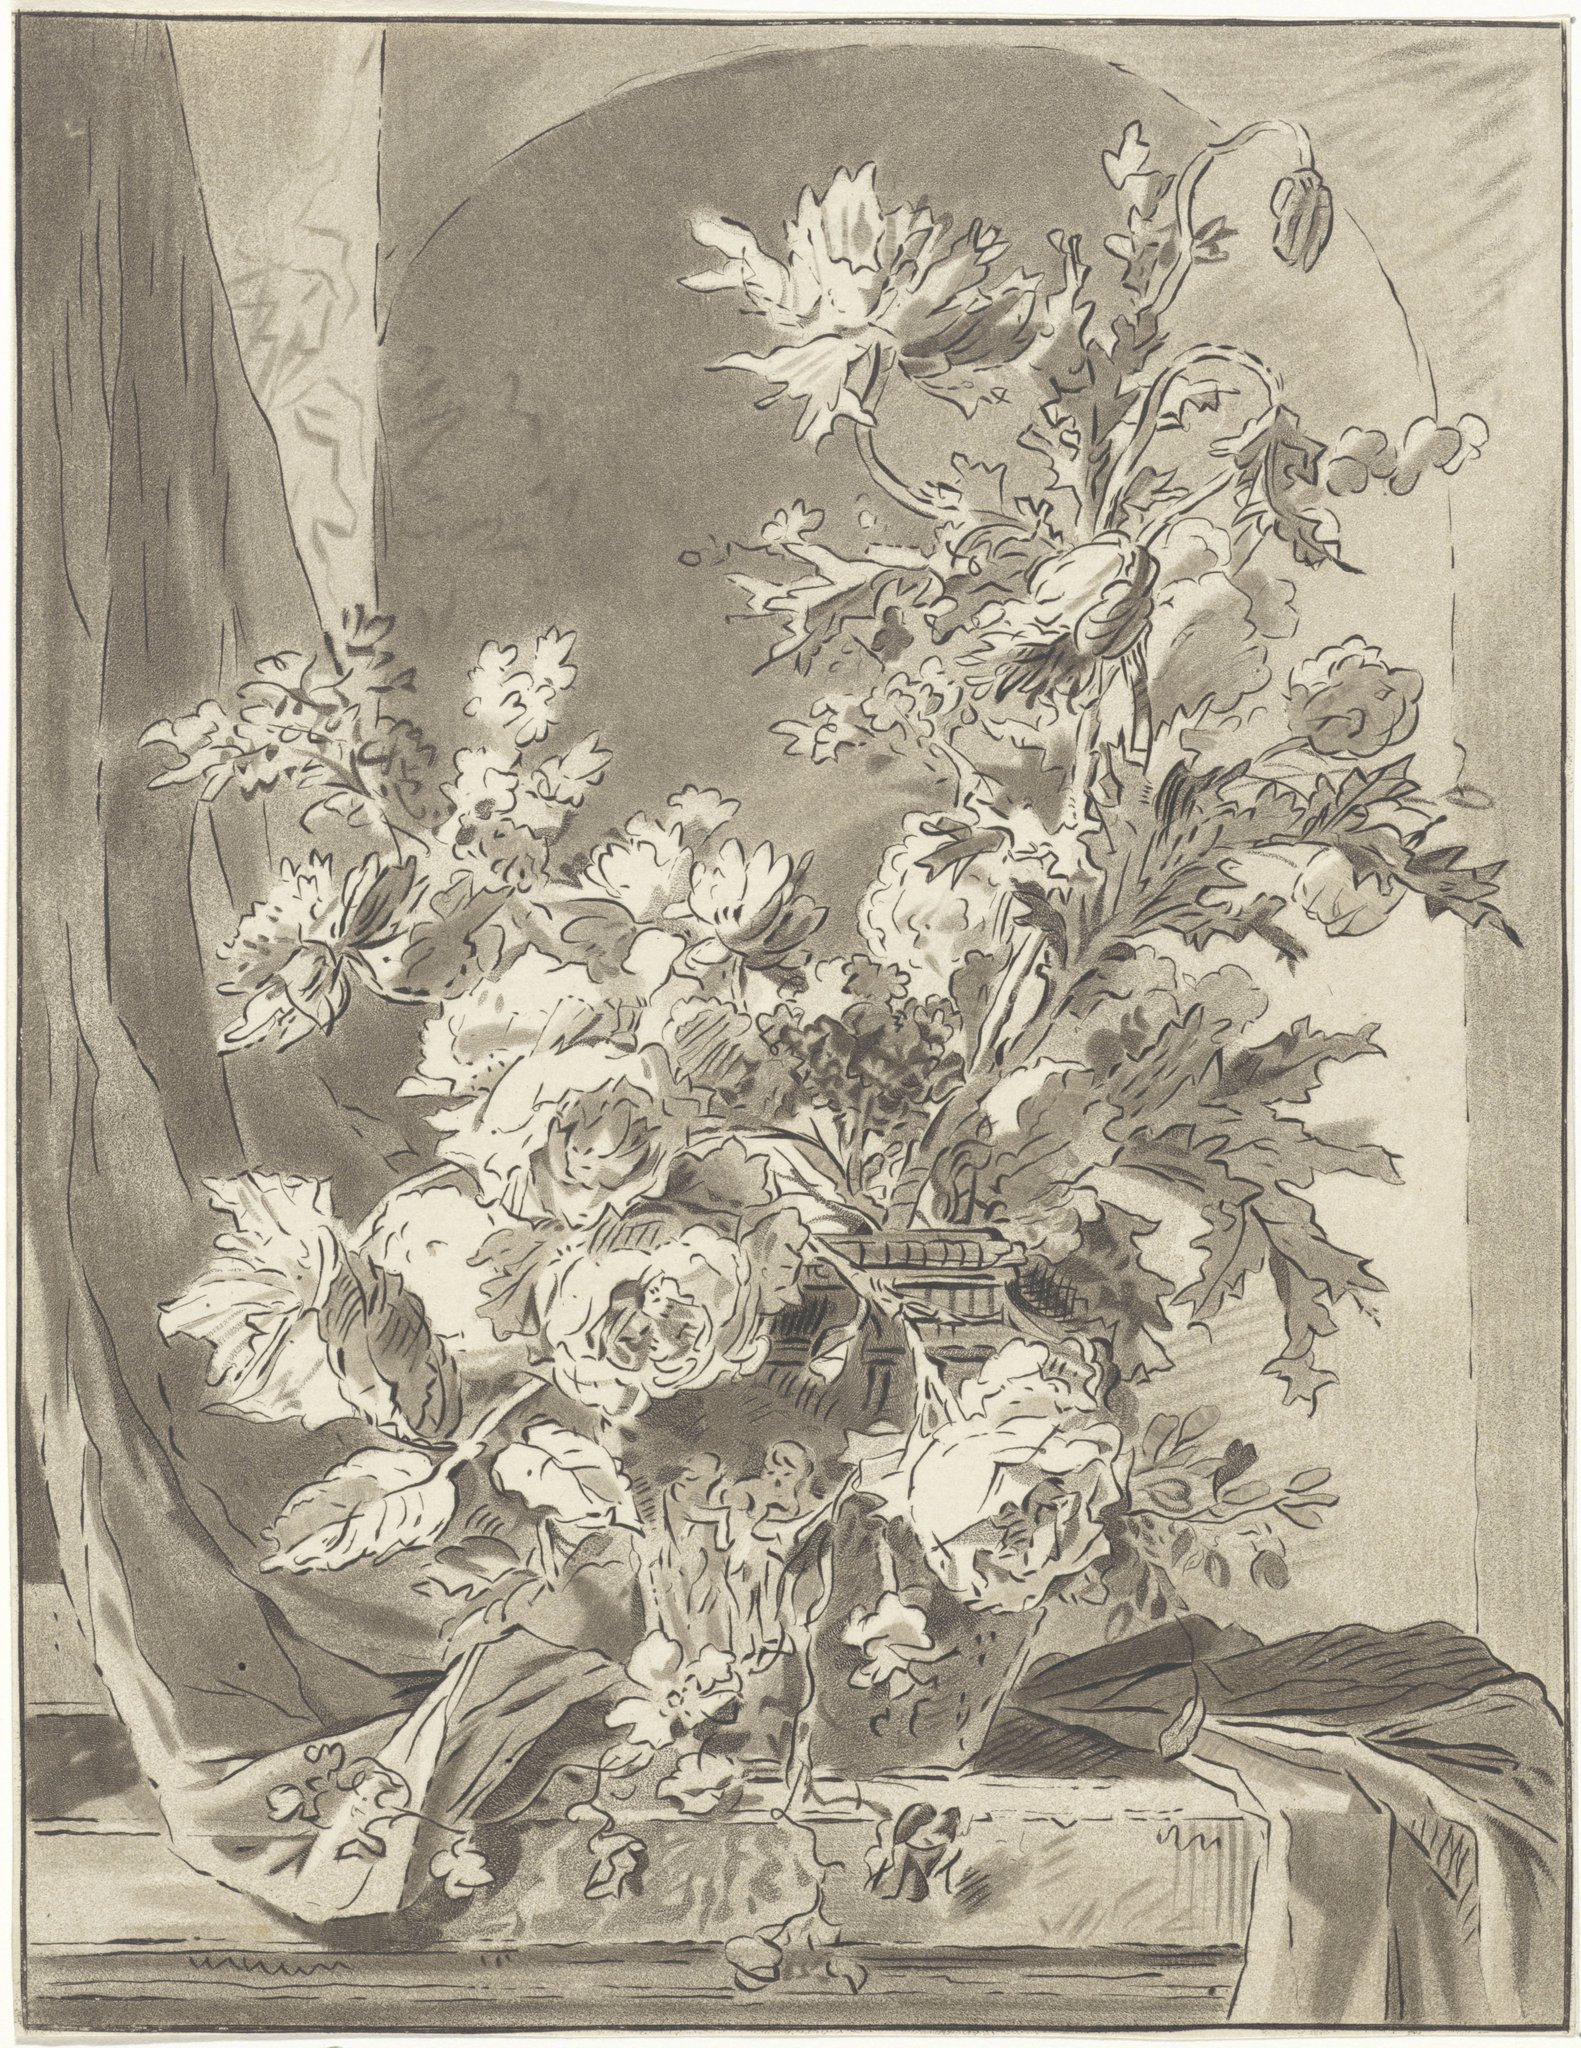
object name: print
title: Vaas met bloemen voor een nis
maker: bernhard schreuder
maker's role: print maker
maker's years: -1780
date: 1767-1780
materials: paper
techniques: etching, rocker stamped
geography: netherlands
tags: flowers in a vase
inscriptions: collector's mark: Lugt 240